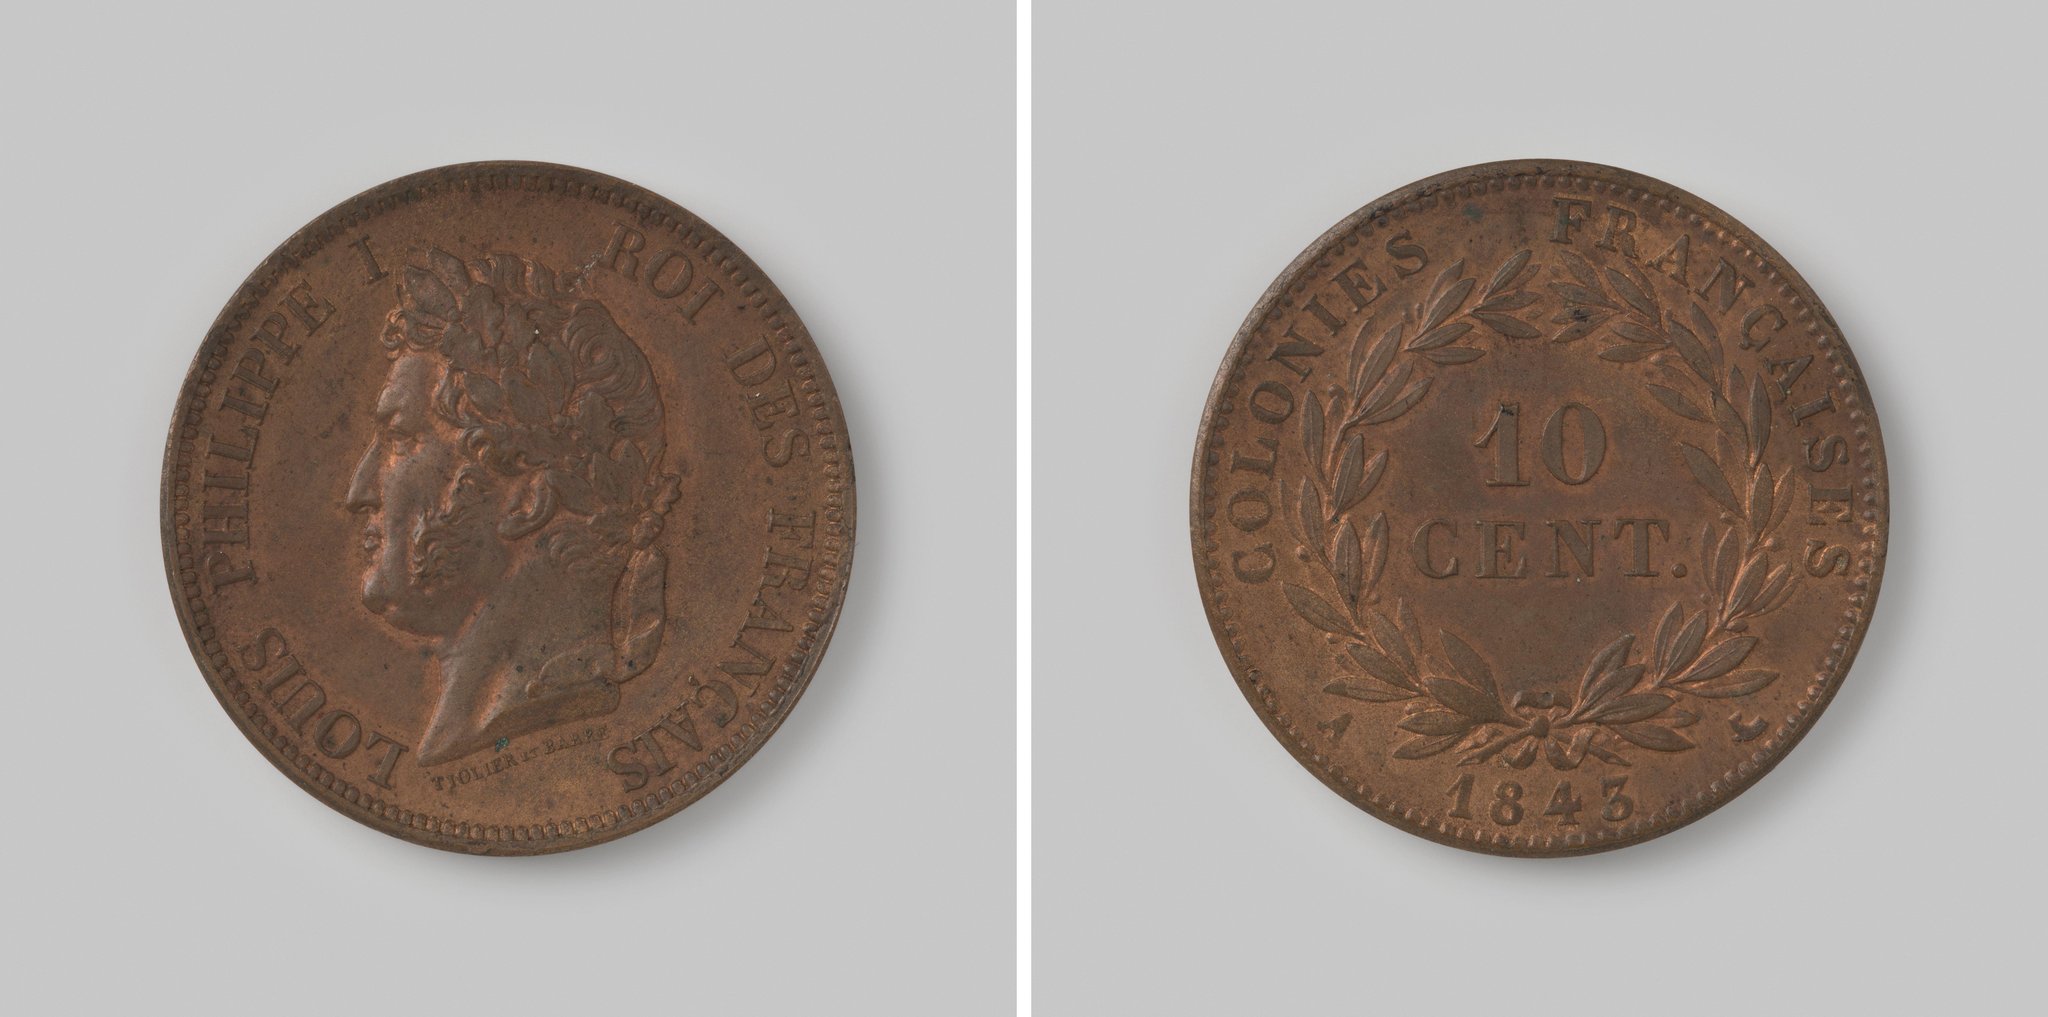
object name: tien centime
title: 10 centimes van de Franse koloniën tijdens Louis Philippe I, 1843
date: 1843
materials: bronze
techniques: striking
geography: paris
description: Bronzen munt. Voorzijde: gelauwerd hoofd van Louis Philippe I naar links. Keerzijde: binnen een krans van twee takken in twee regels waaarde-aanduiding. Omschrift: COLONIES FRANCAISES. Onderaan jaartal, links daarvan letter A [=Parijs].